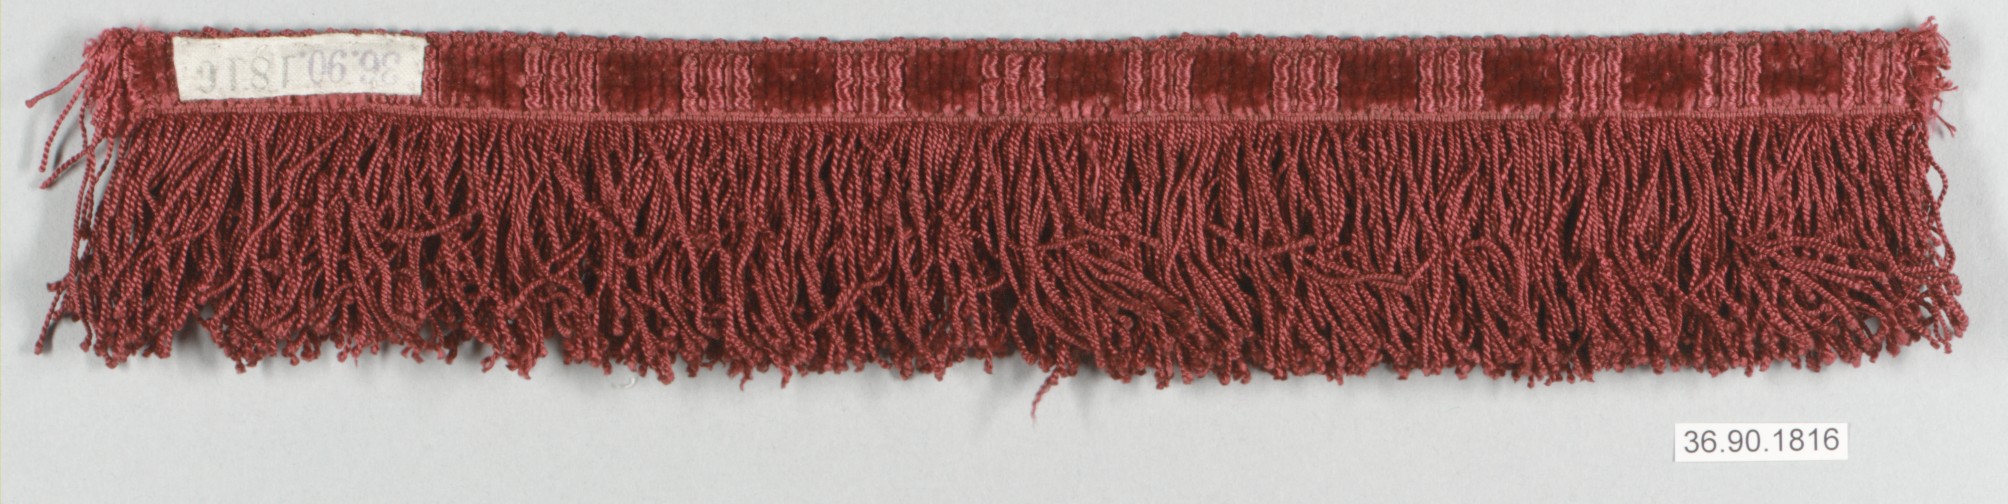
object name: fringe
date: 1834-1866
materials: silk